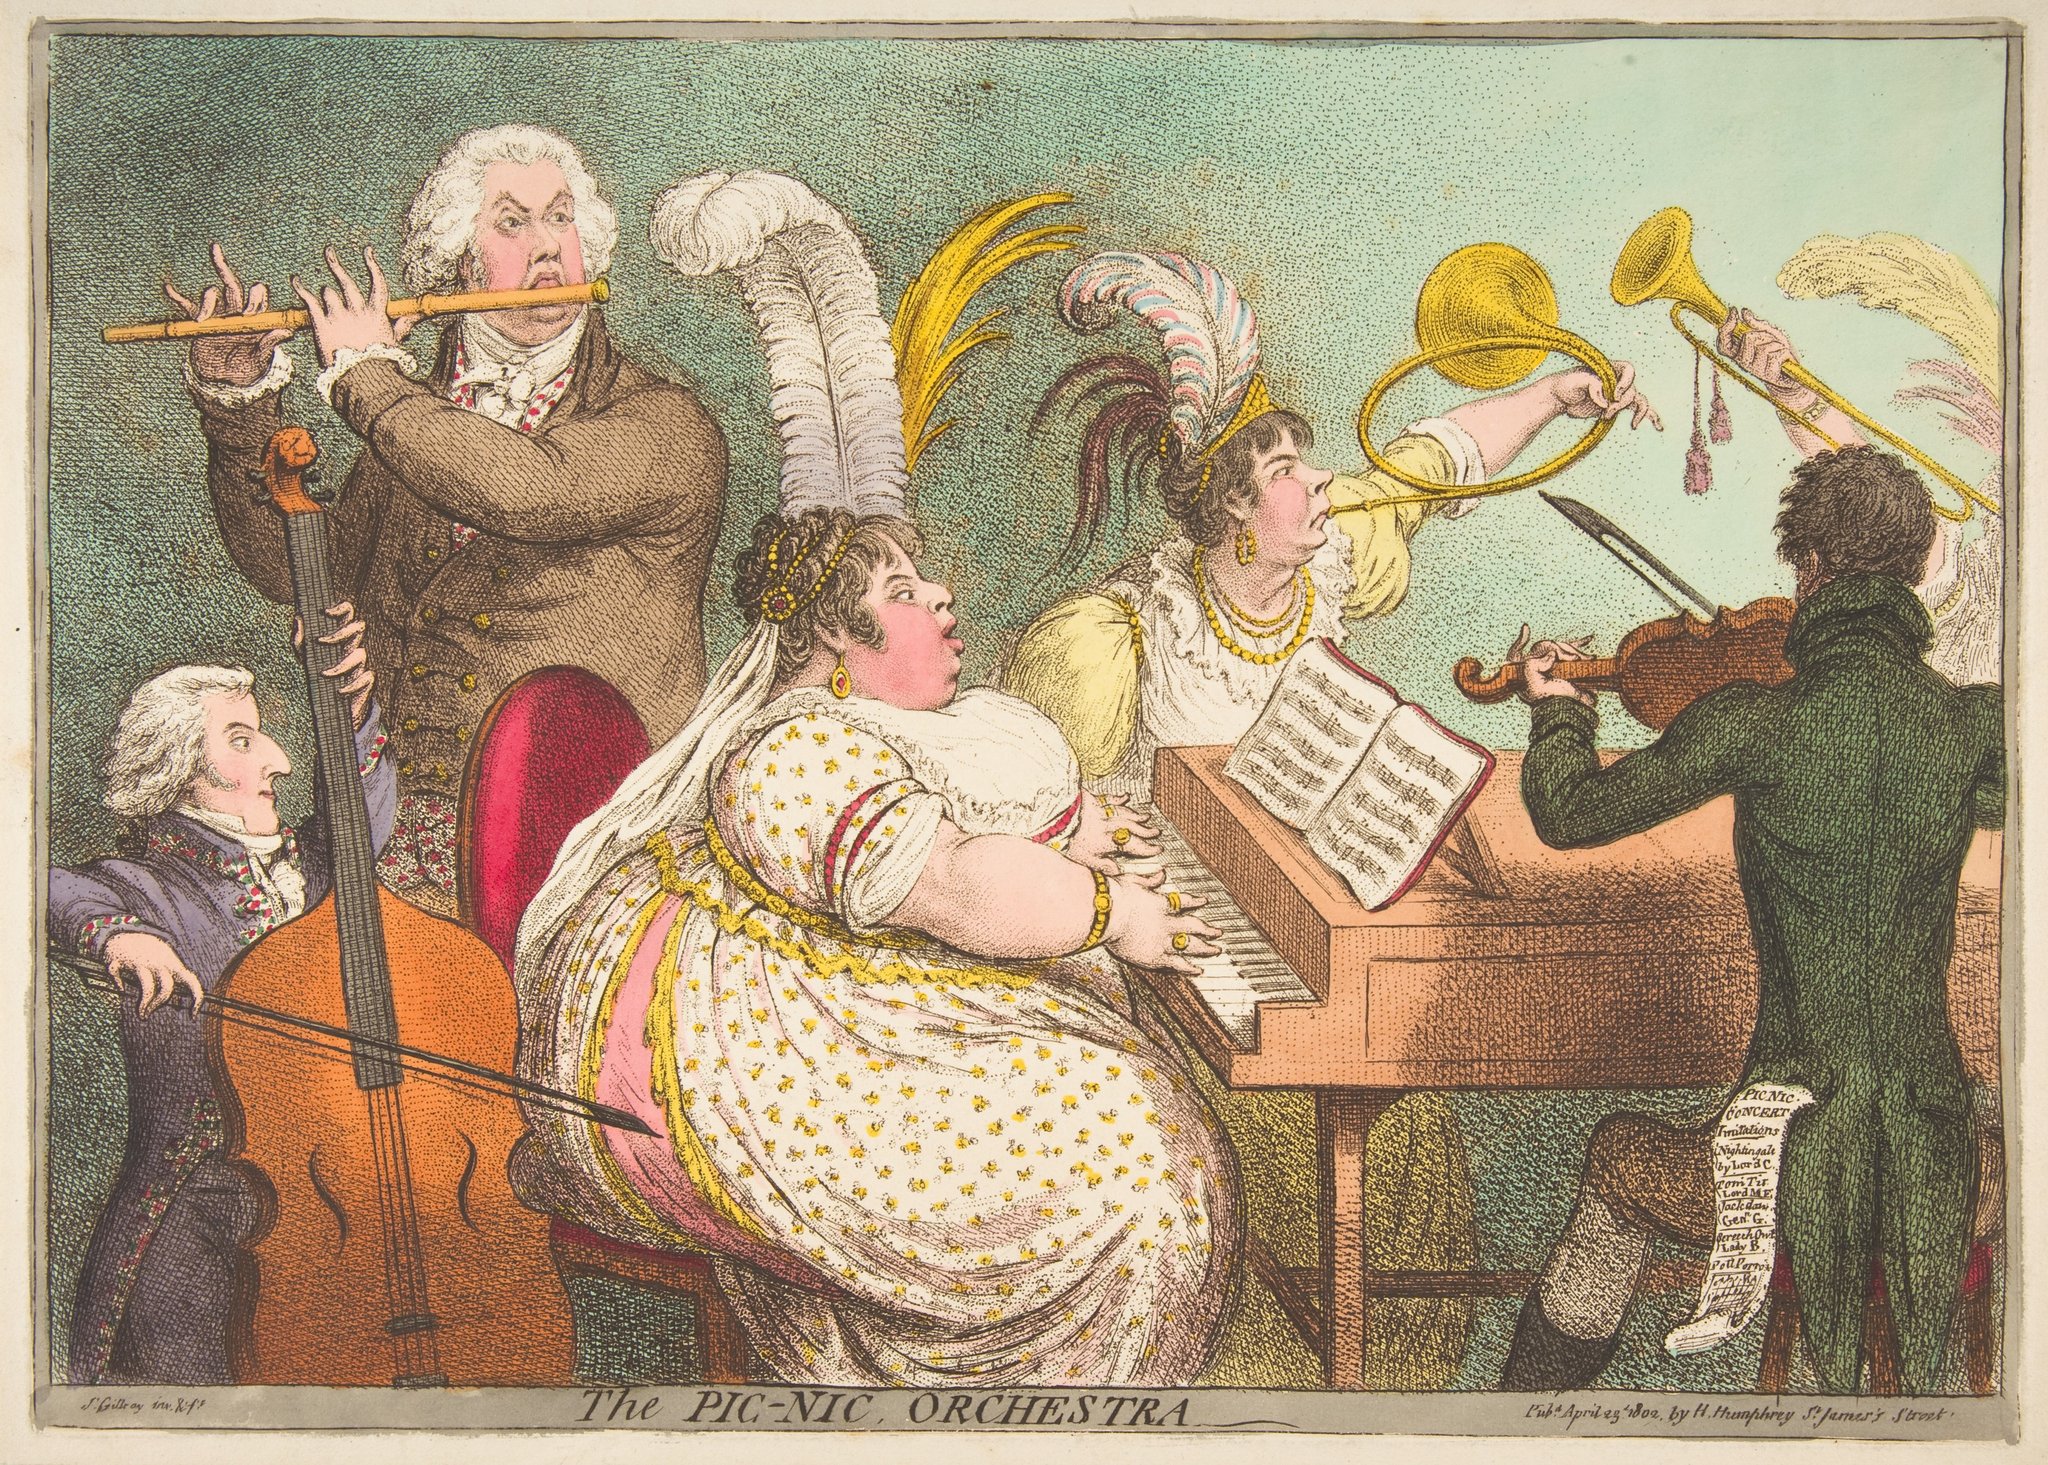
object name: print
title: The Pic-Nic Orchestra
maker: james gillray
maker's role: artist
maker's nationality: british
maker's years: 1756-1815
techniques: engraving, etching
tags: men,women,cellos,flutes,pianos